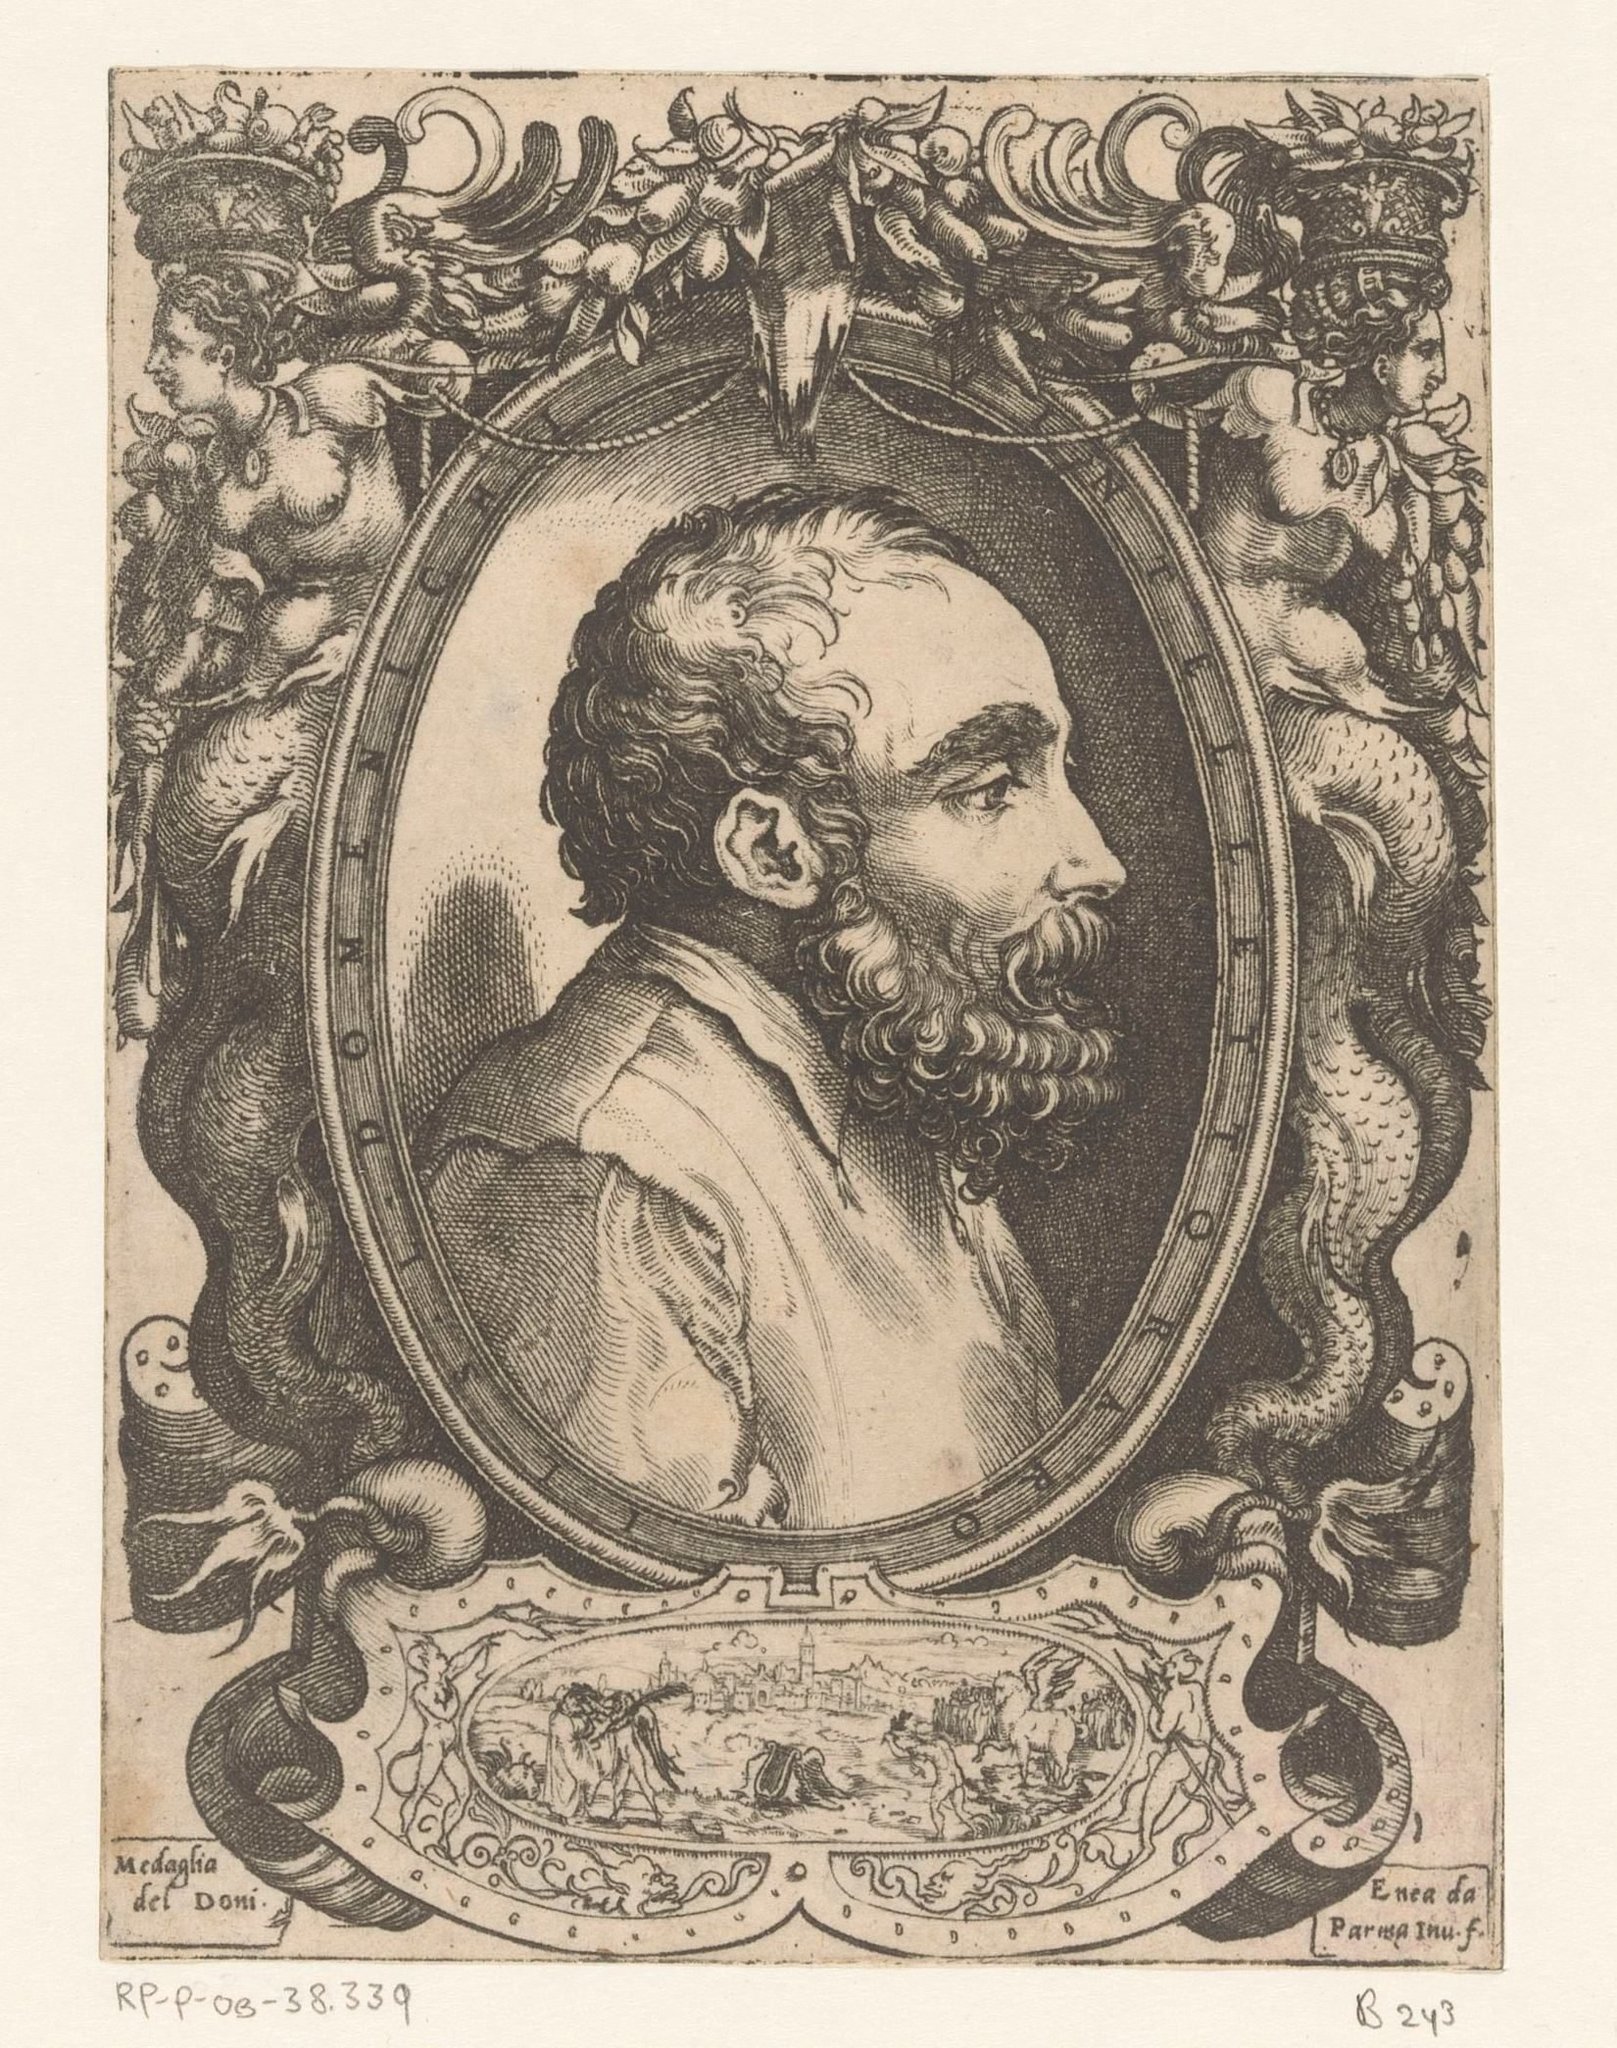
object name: print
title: Medaglie del Doni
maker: enea vico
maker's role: draughtsman, print maker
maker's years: 1523-1567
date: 1550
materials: paper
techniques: engraving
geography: italy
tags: historical persons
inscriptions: collector's mark: Lugt 12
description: Portret van Lodovico Domenichi, gevat in een geornamenteerde lijst. Onder het portret een ovale voorstelling.